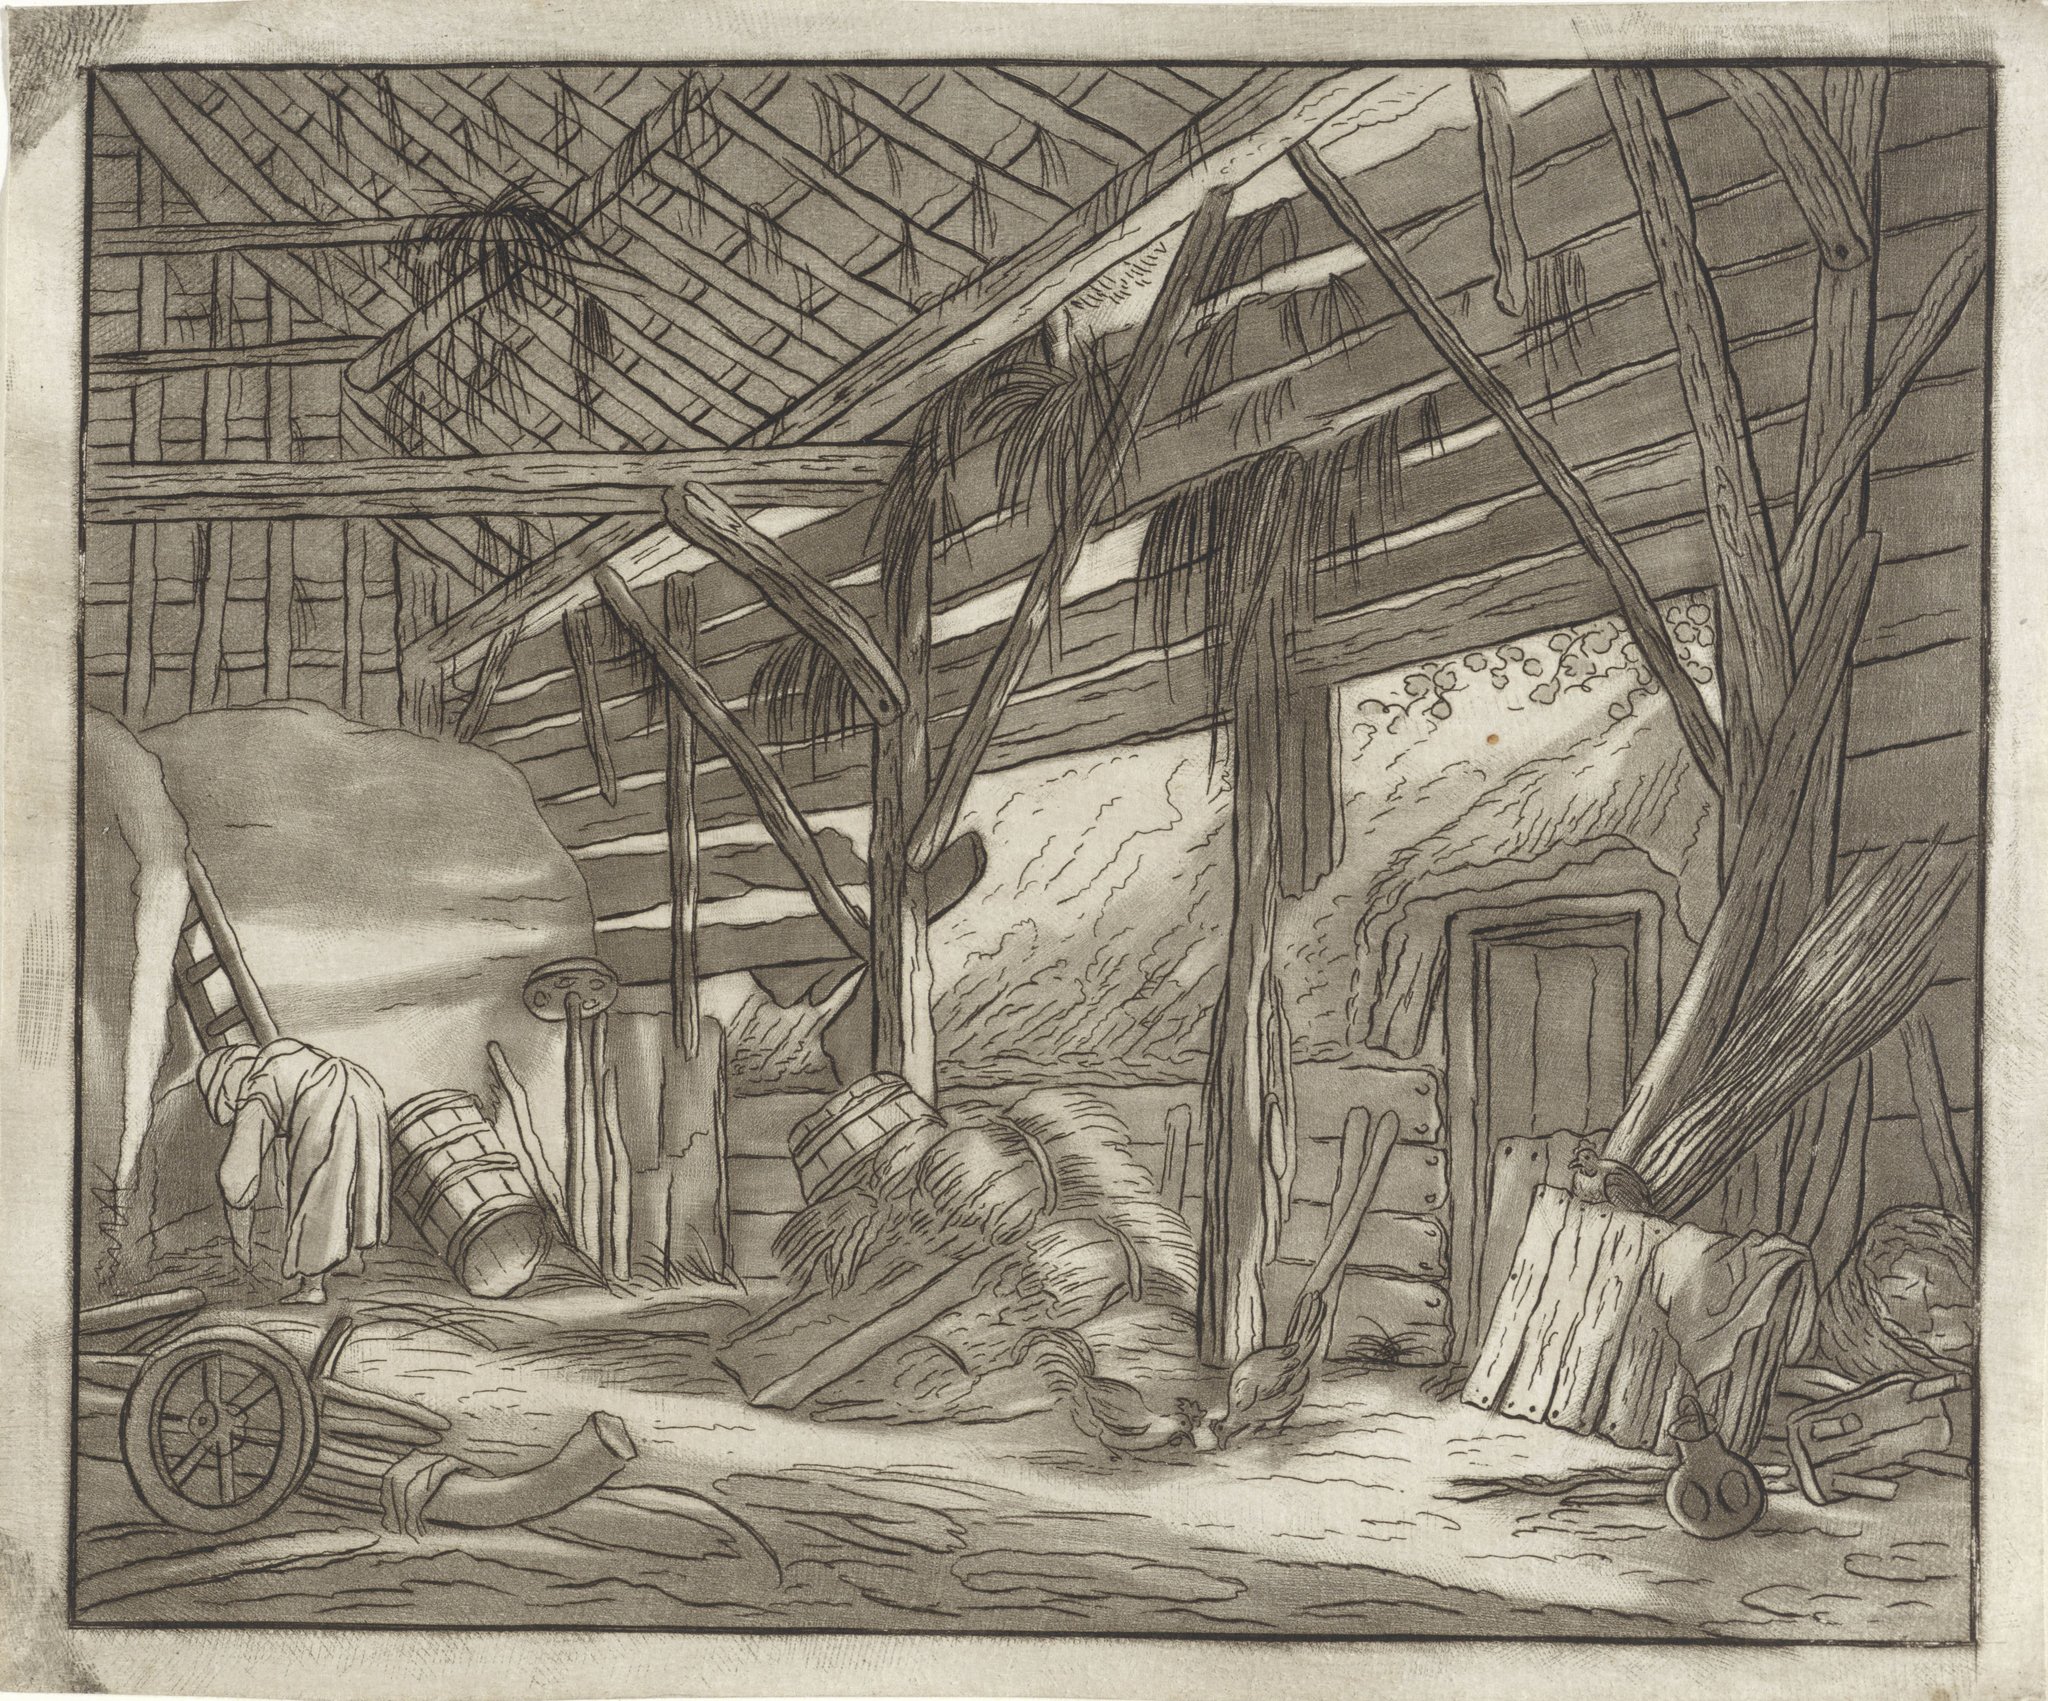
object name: print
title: Boerenschuur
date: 1767-1780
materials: paper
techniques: etching, rocker stamped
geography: amsterdam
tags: barn - aa - civic architecture: inside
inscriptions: collector's mark: Lugt 2228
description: Deze prent in kleur gedrukt opgenomen in: Het werk van den alöm beroemde konstschilder Adriaan van Ostade, volgens de mannier als teekeningen in het koper gebragt, en met alle zyn kleuren gedrukt, door het Overyssels konstgenootschap, onder de zinspreuk Artium Tristis Janua. Amsterdam: Frederik Willem Greebe, [voor 1780].